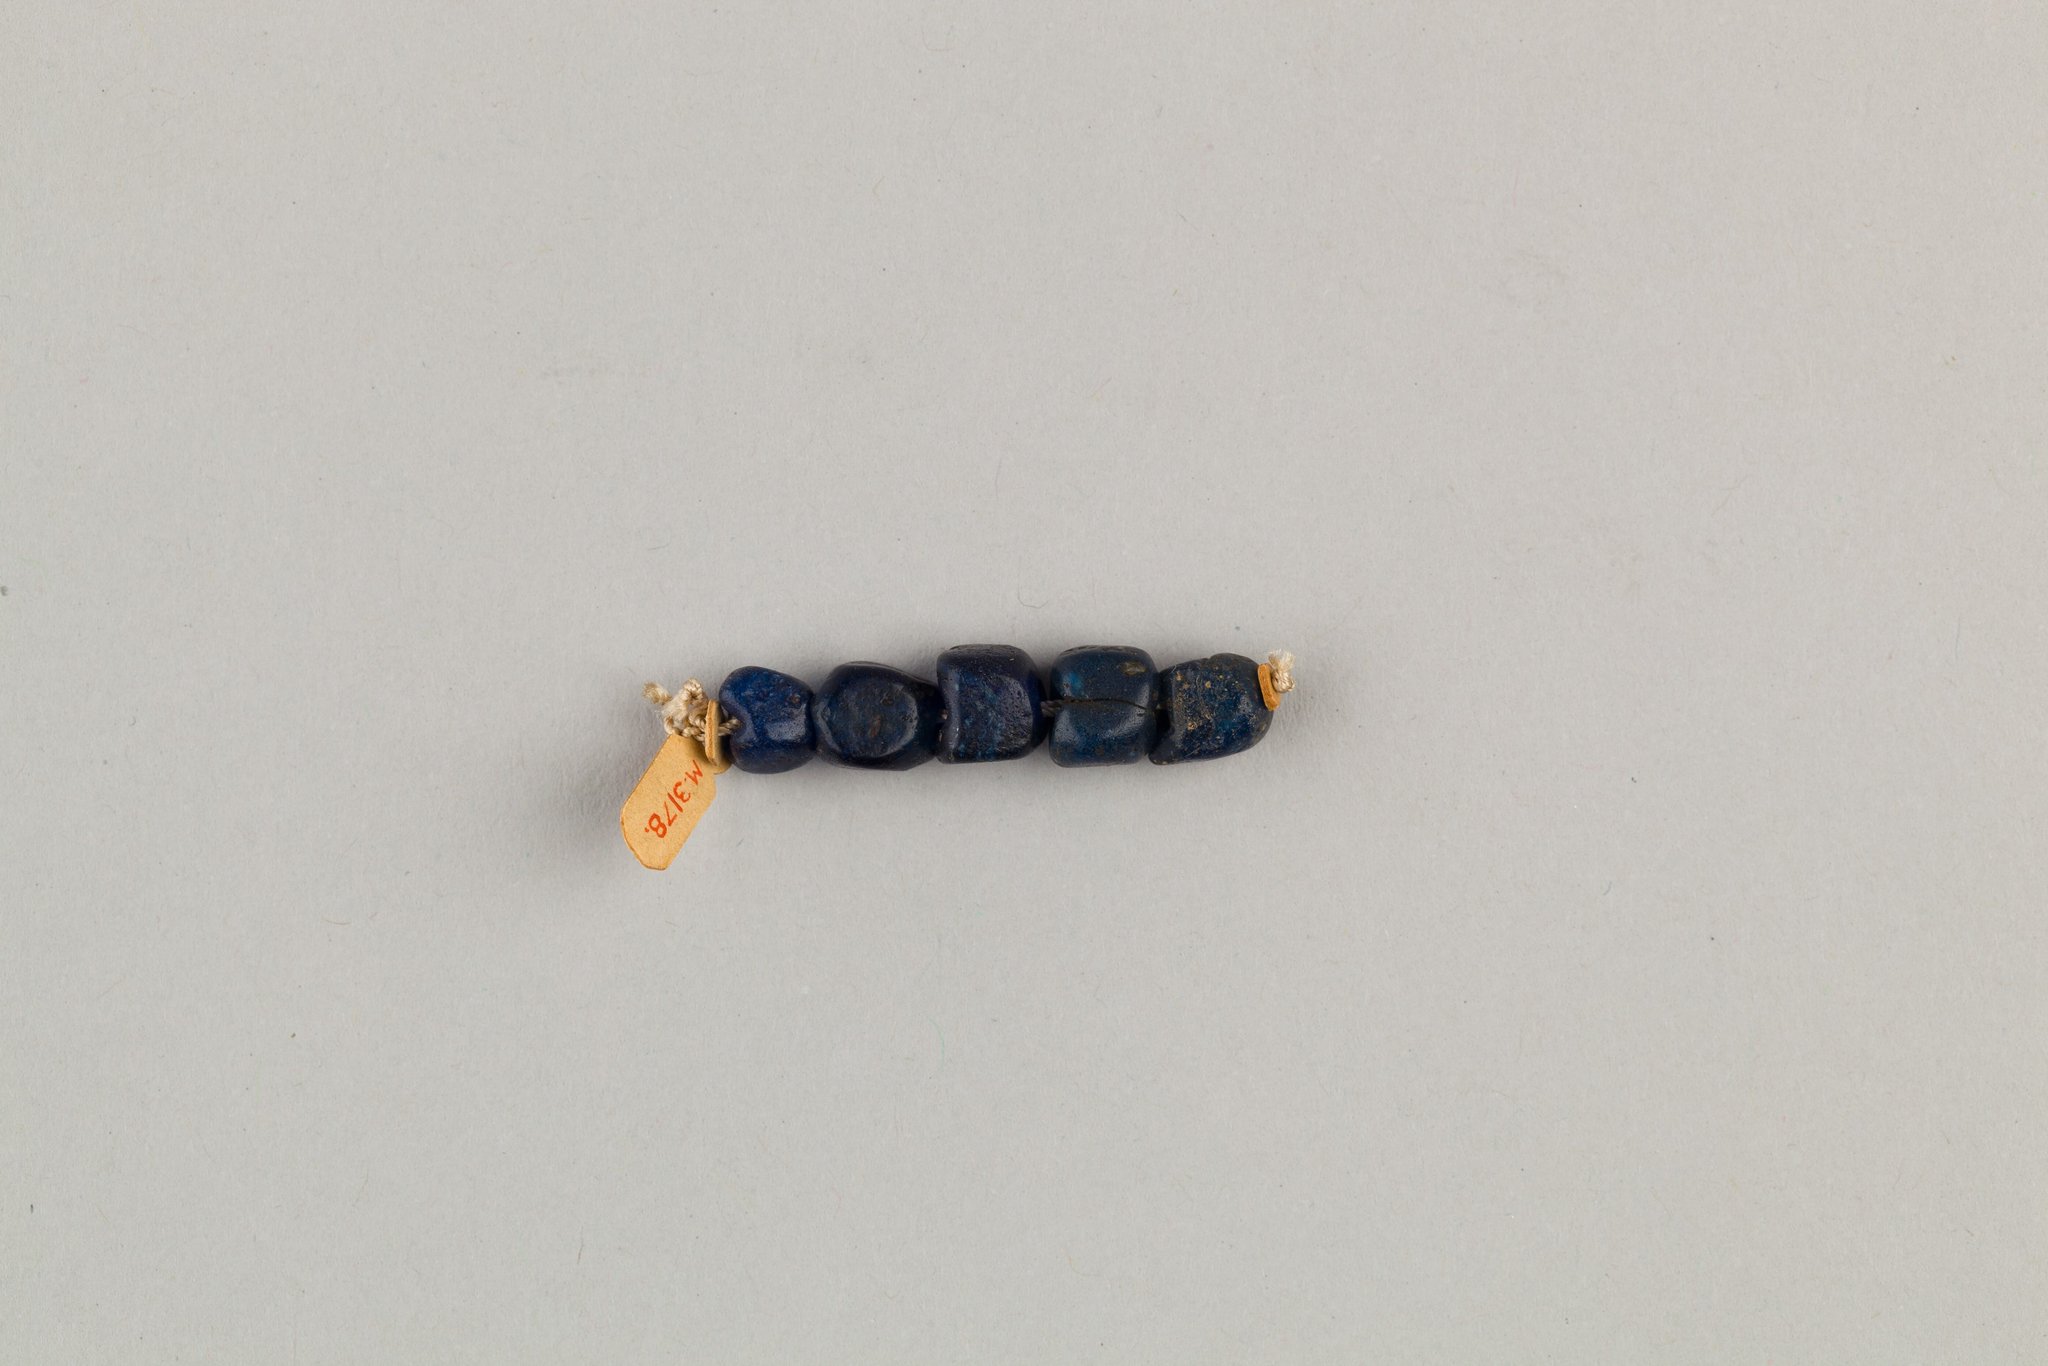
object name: bead, string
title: String of 5 four-sided beads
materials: glass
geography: egypt